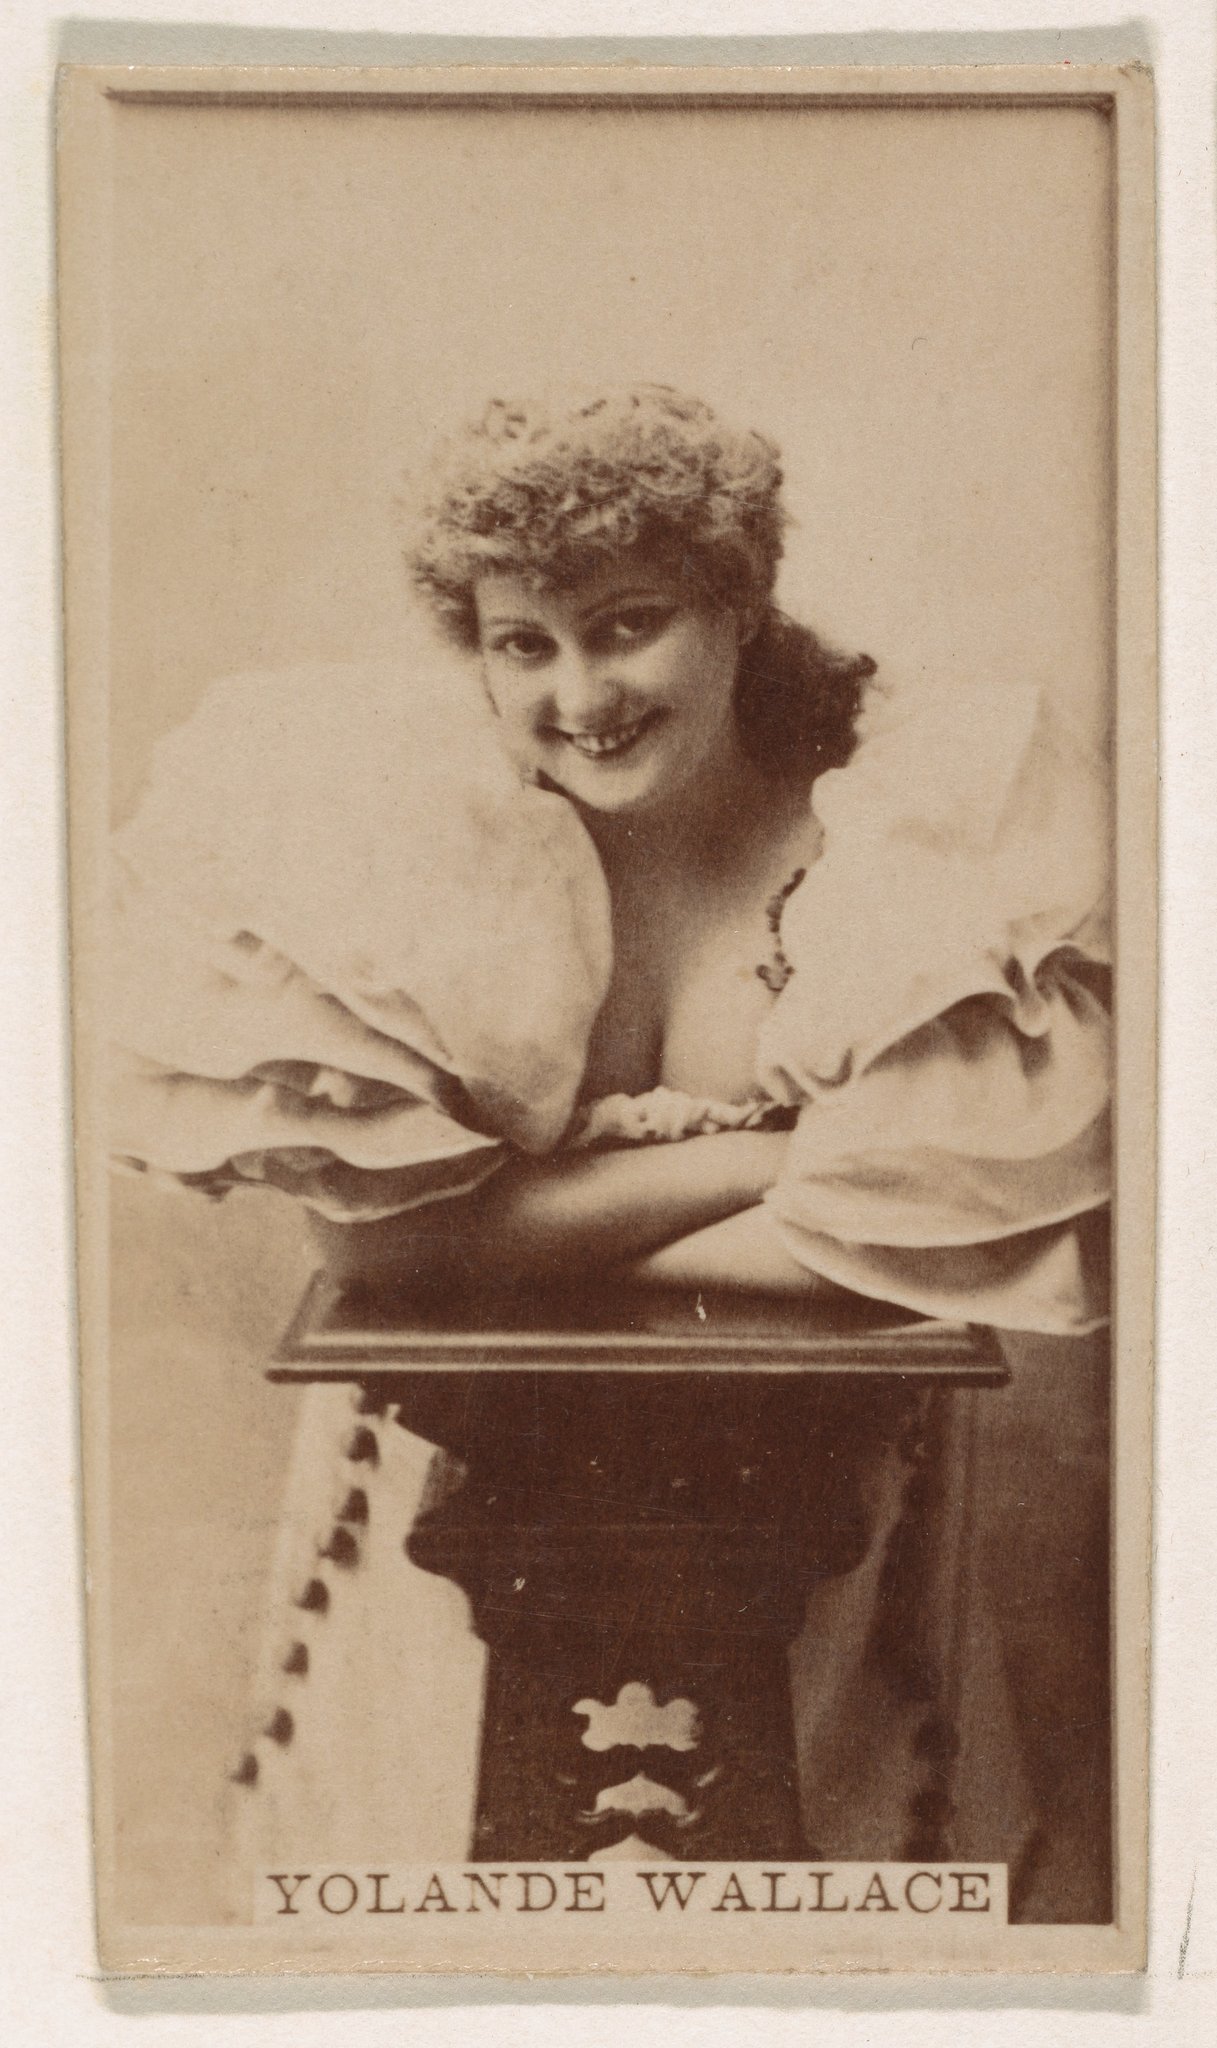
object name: photograph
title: Yolande Wallace, from the Actresses series (N245) issued by Kinney Brothers to promote Sweet Caporal Cigarettes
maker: kinney brothers tobacco company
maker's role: publisher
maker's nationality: american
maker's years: 1869-2011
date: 1890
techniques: albumen silver print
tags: portraits,women,actresses